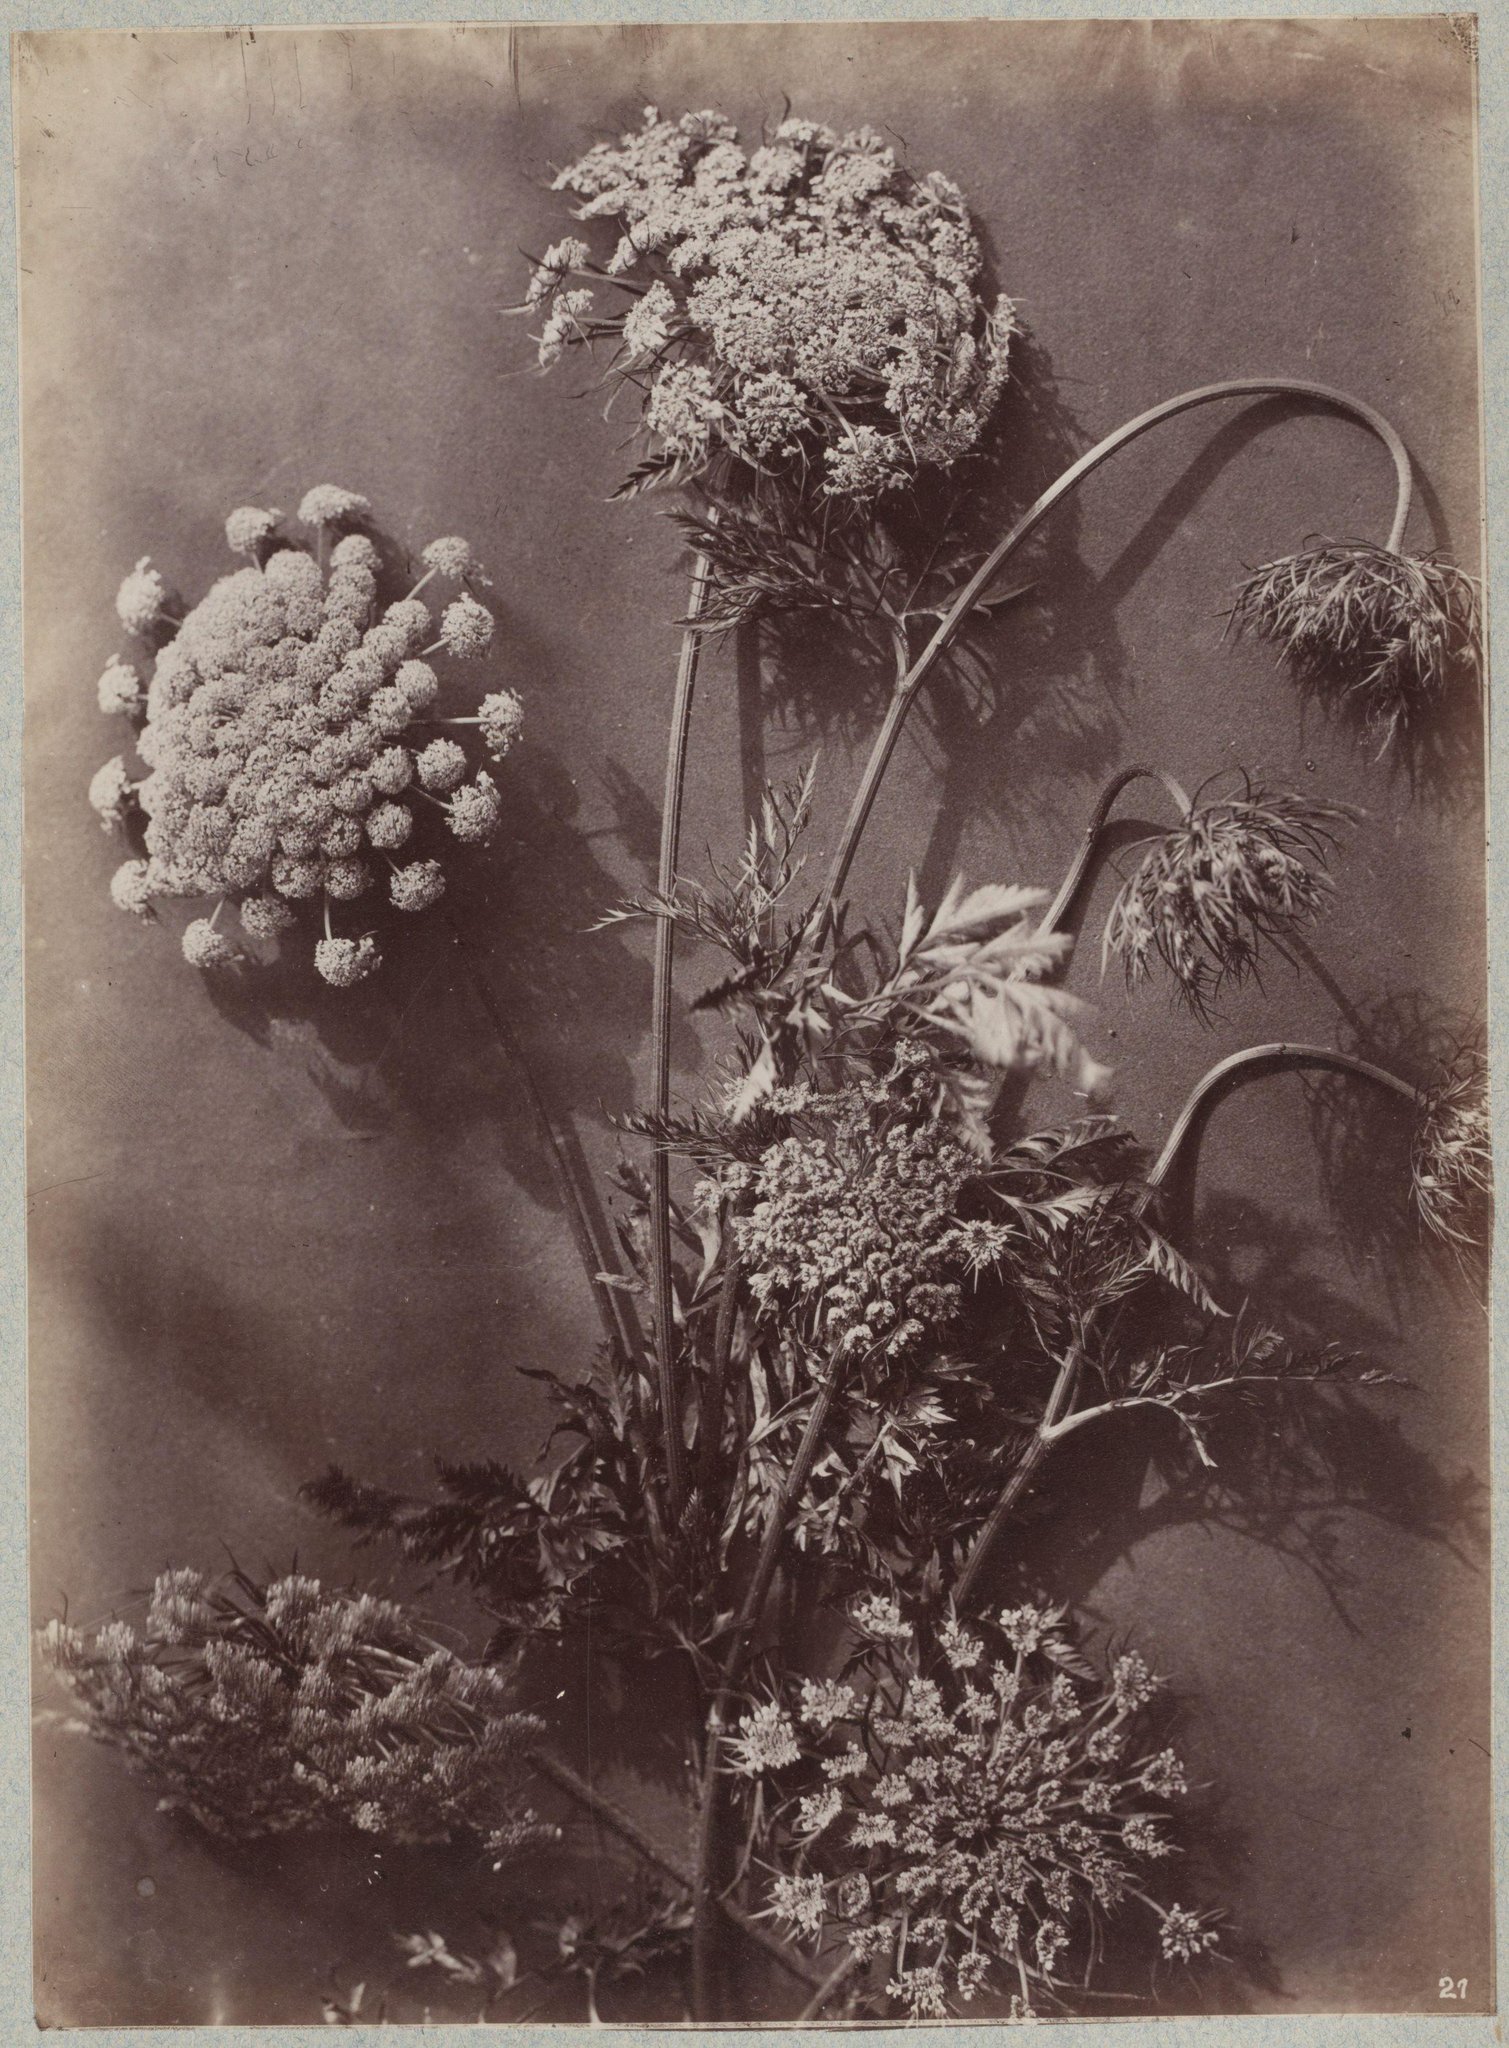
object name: photograph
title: Bloemstudie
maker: a. calavas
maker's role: publisher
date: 1875-1895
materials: cardboard, photographic support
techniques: albumen print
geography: paris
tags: flowers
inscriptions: collector's mark: Lugt 3937, number: ‘21’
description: Onderdeel van Verzamelband met foto's van bloemstudies.